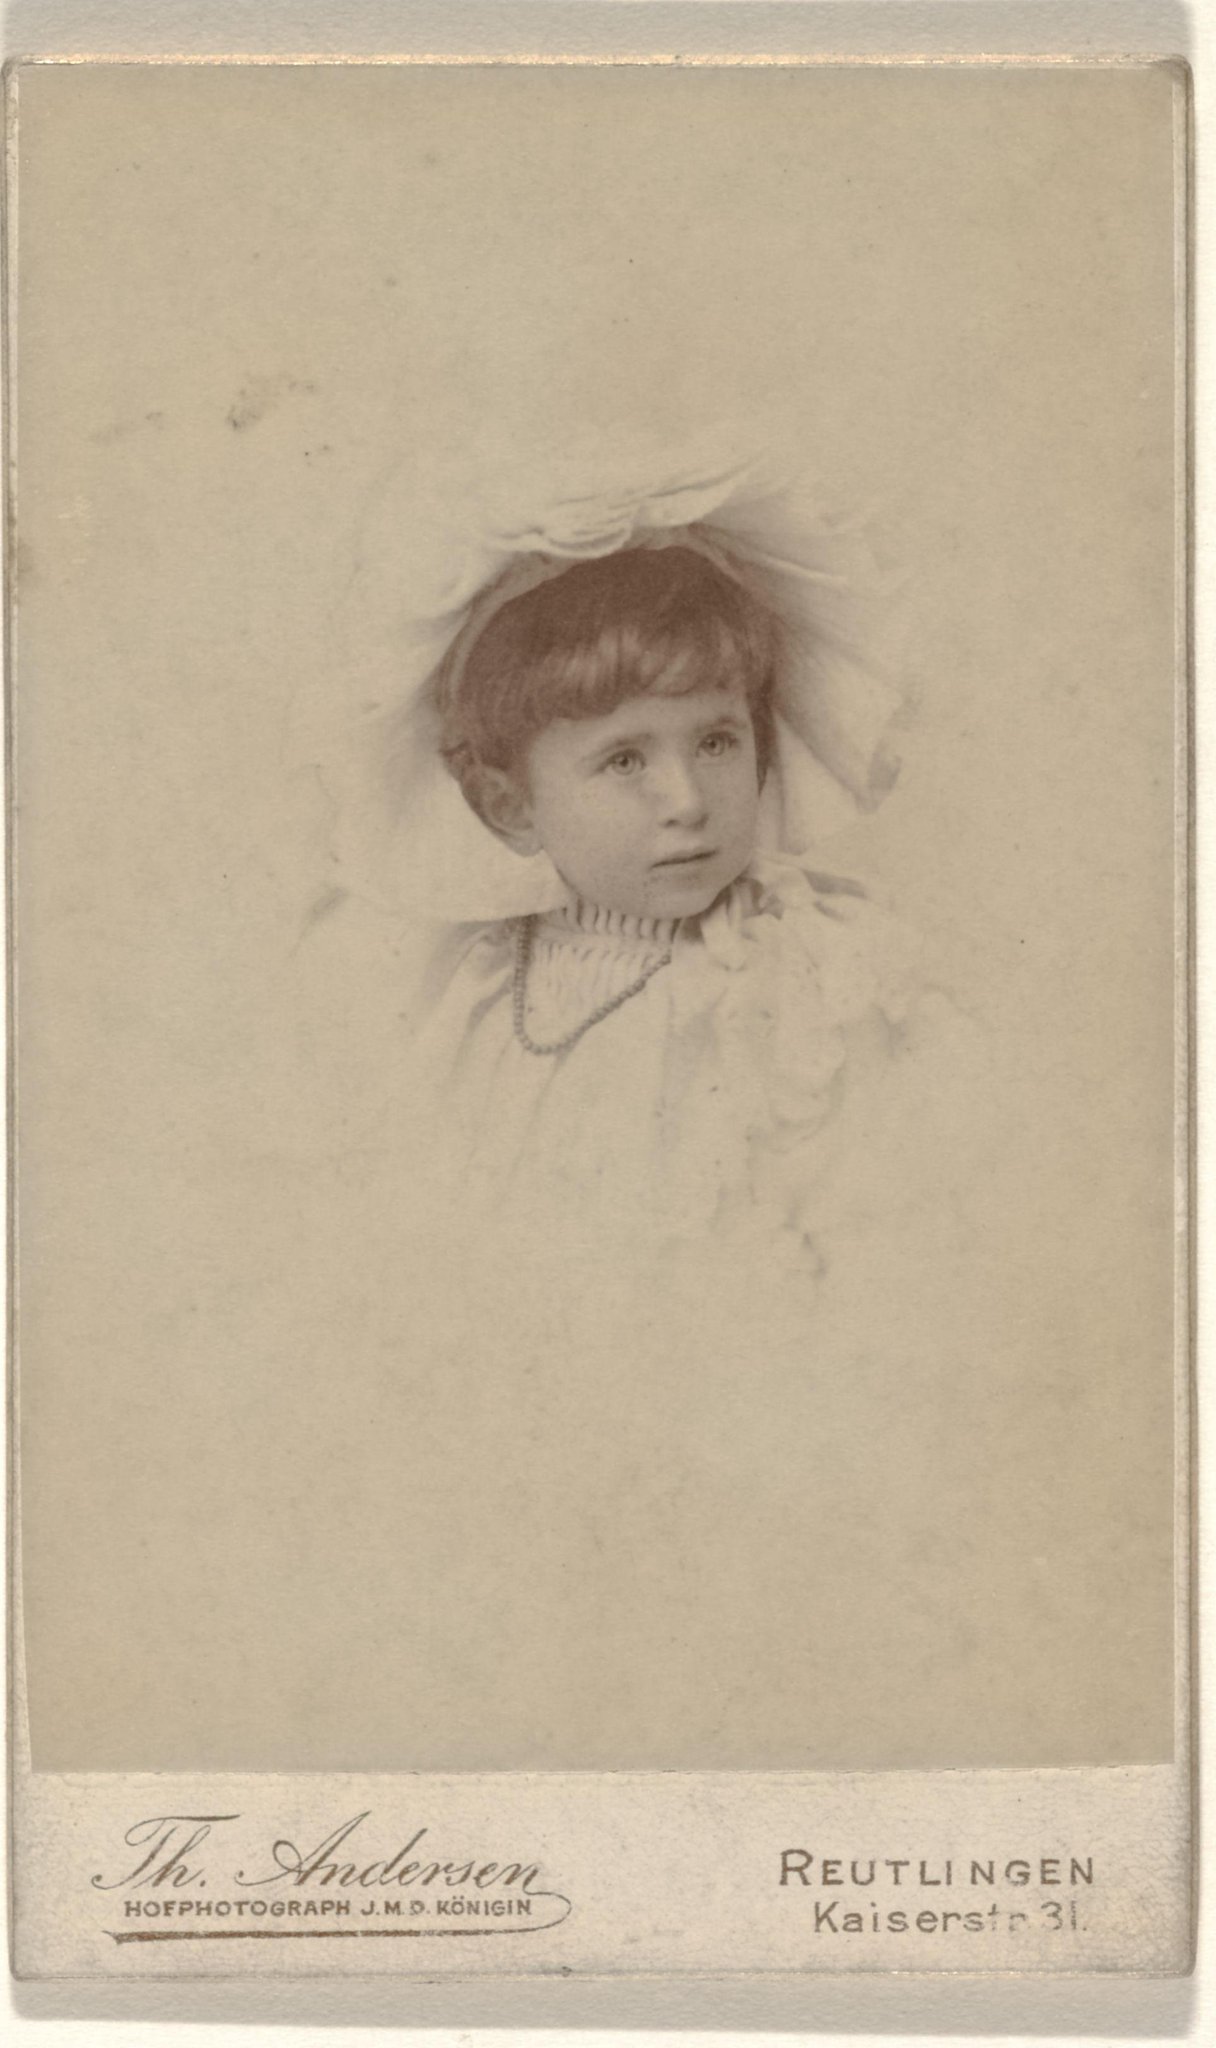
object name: photograph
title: Jong kind, vermoedelijk Else Wachenheimer-Moos, in kinderjurk met kort haar, hoofddeksel en ketting om de nek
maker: theodor andersen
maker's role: fotograaf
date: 1870-1900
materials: photographic support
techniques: gelatin silver print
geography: reutlingen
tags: else wachenheimer-moos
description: Jong kind in kinderjurk met kort haar, hoofddeksel en ketting om de nek.